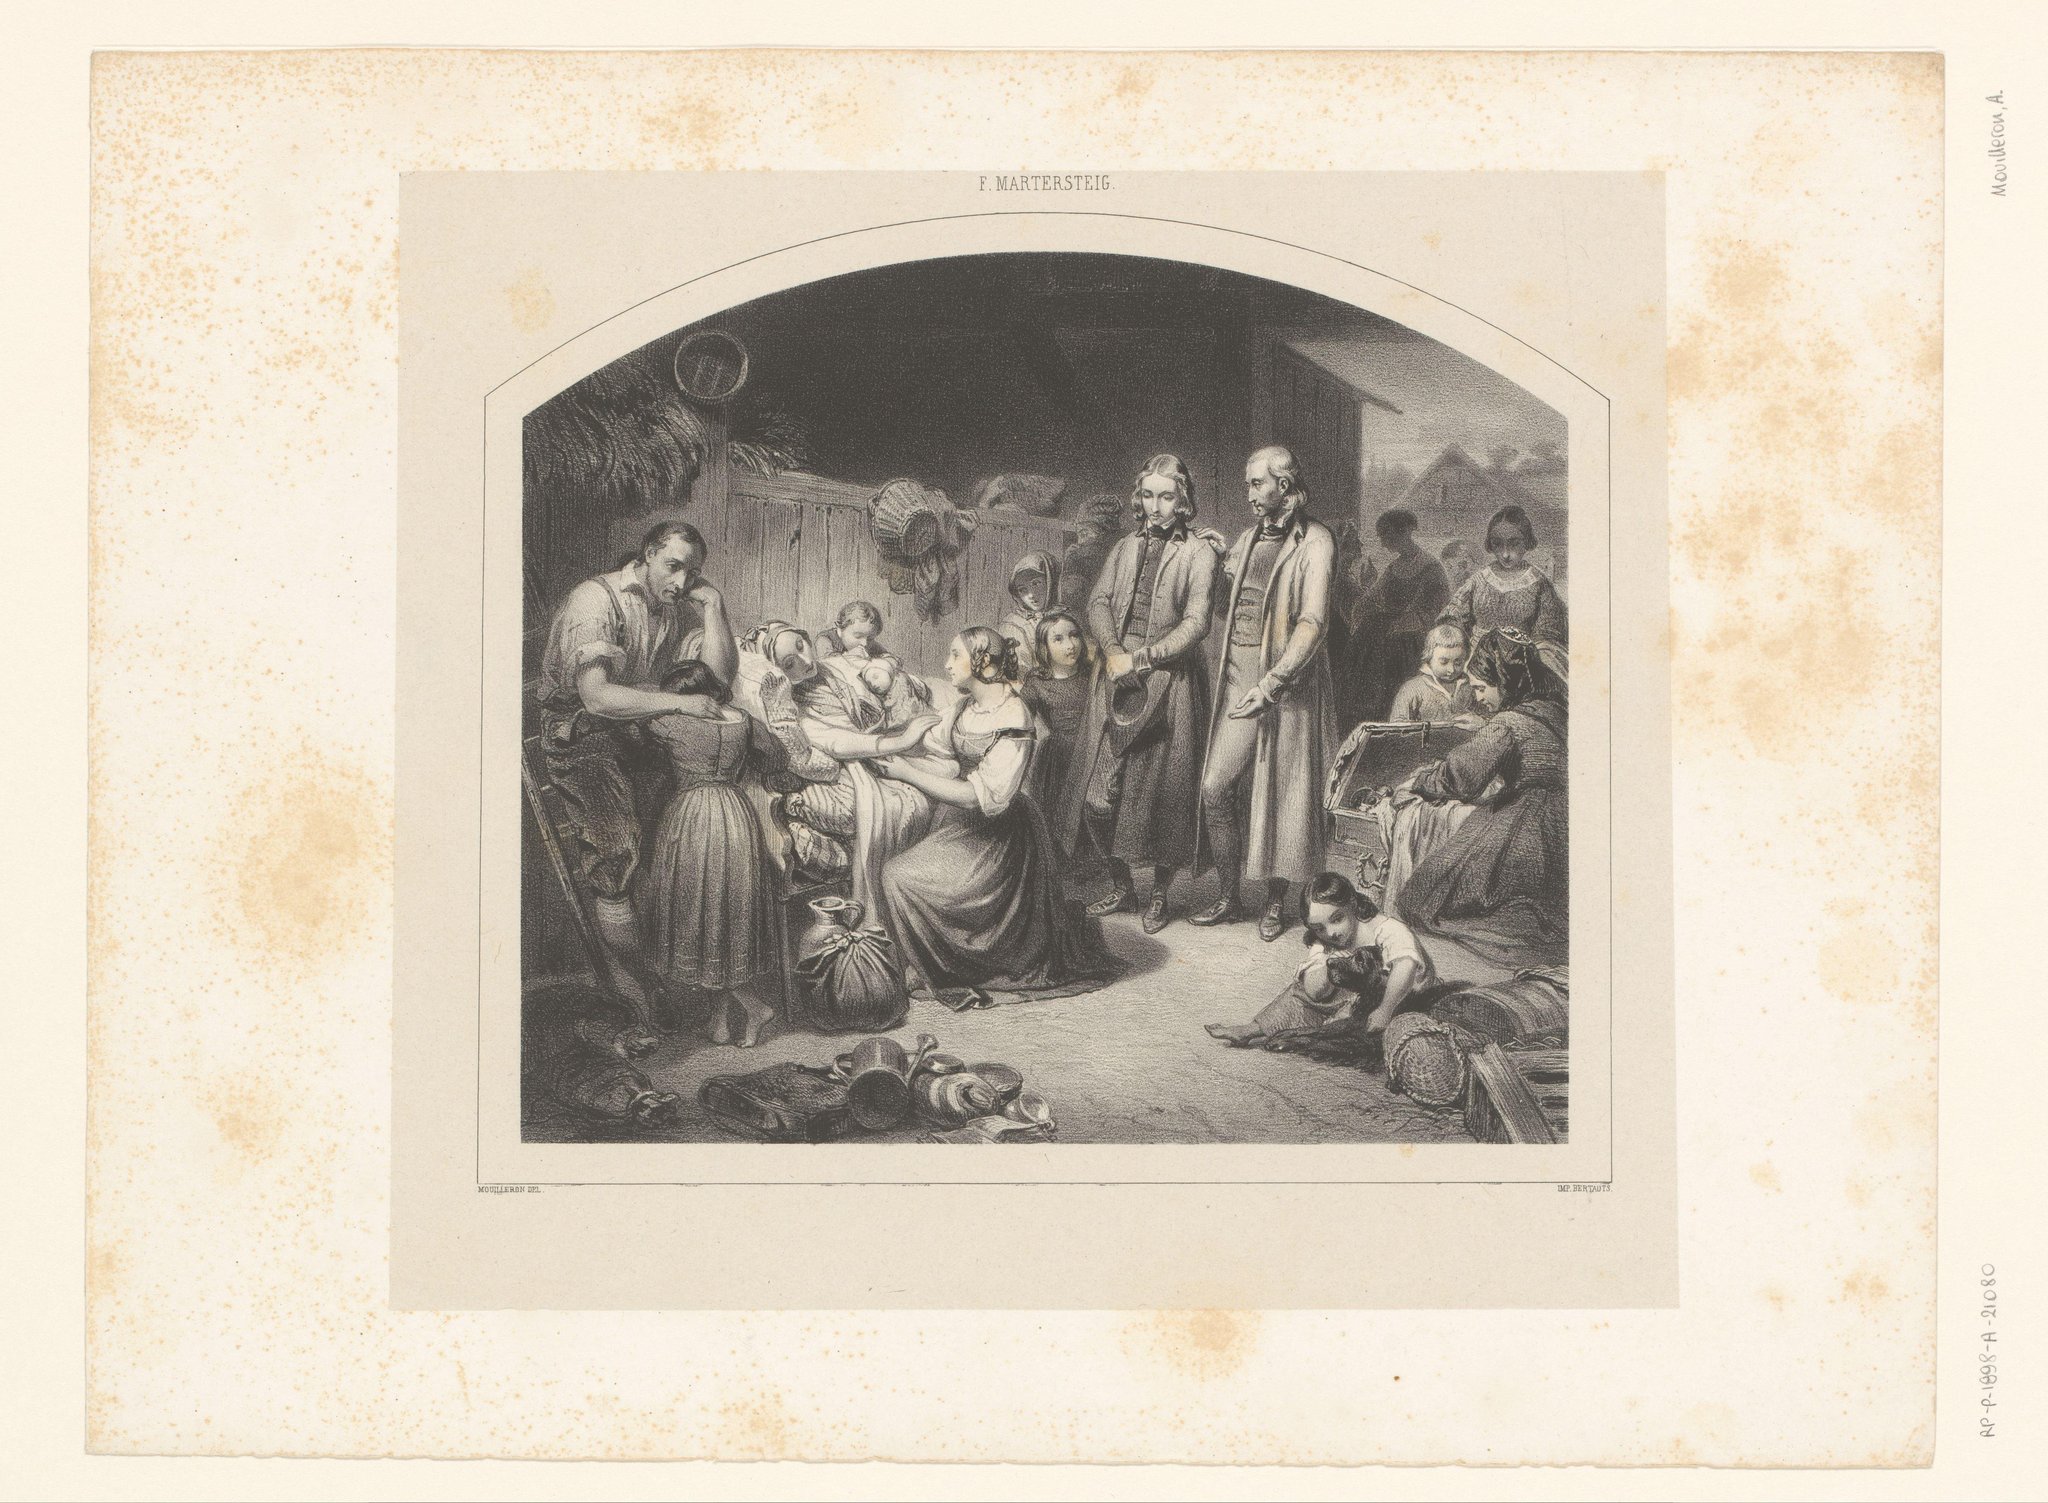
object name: print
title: Reizend gezelschap met kinderen rust uit in een open stal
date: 1830-1880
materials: paper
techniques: lithograph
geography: paris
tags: (traveller) resting in the open air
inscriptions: collector's mark: Lugt 964